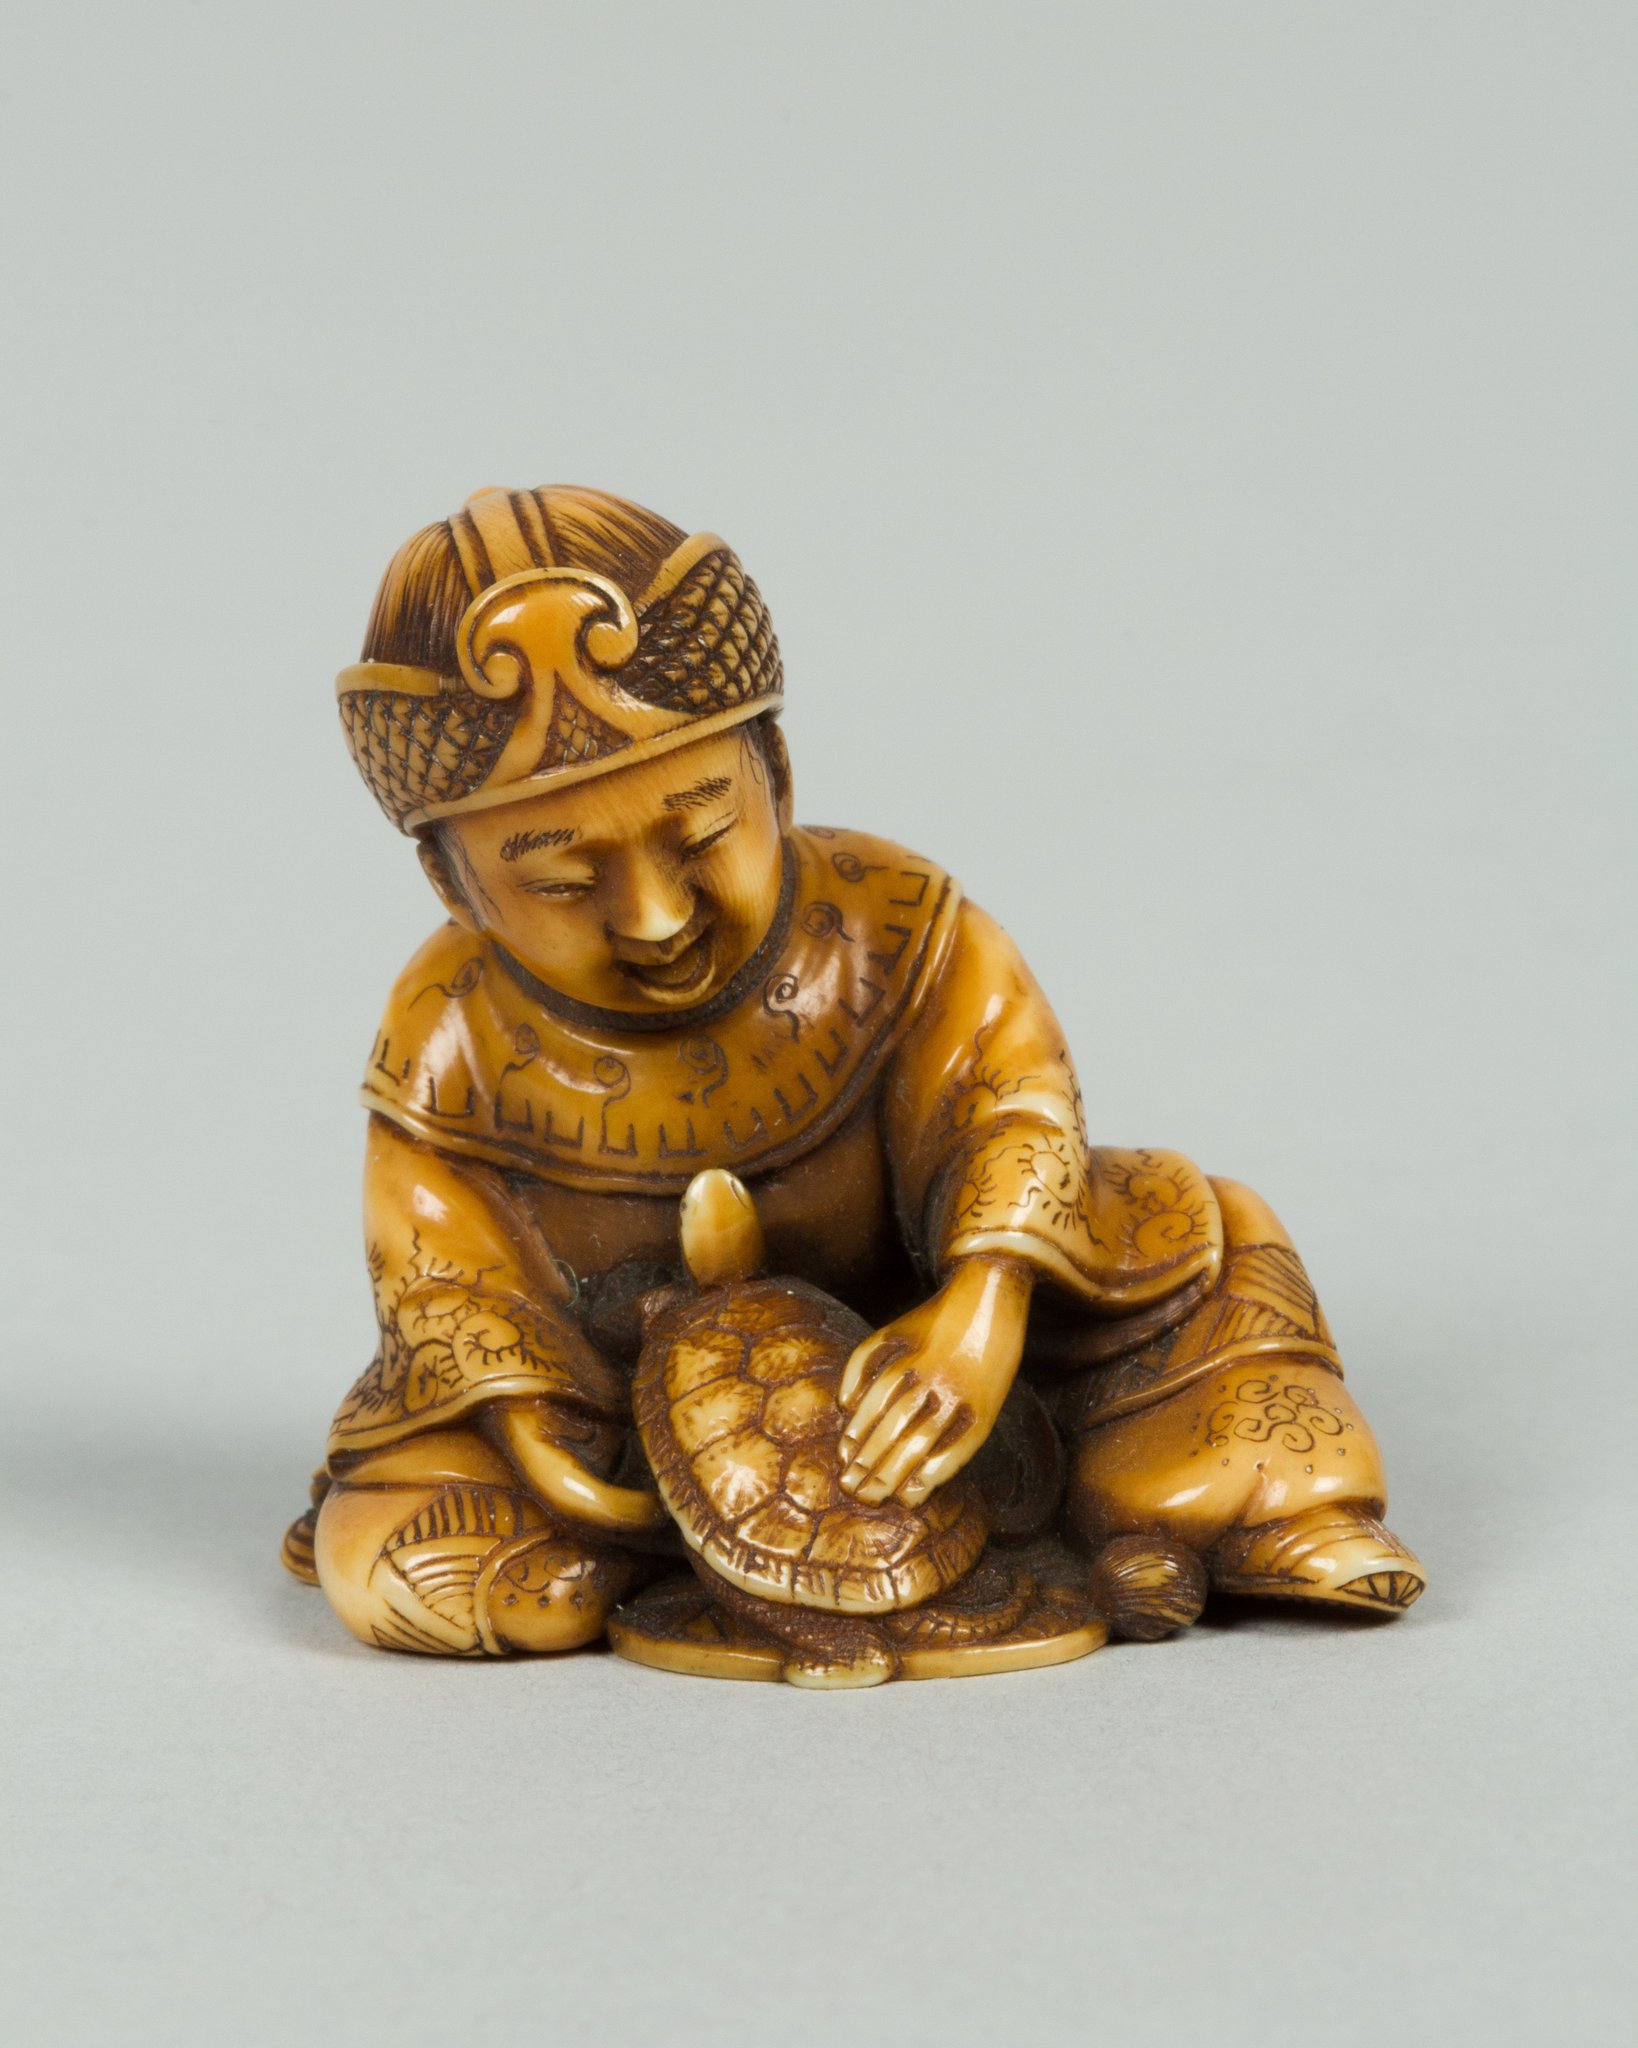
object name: netsuke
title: Netsuke of Boy with Tortoise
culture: japanese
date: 1801-1900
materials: ivory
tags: boys,turtles